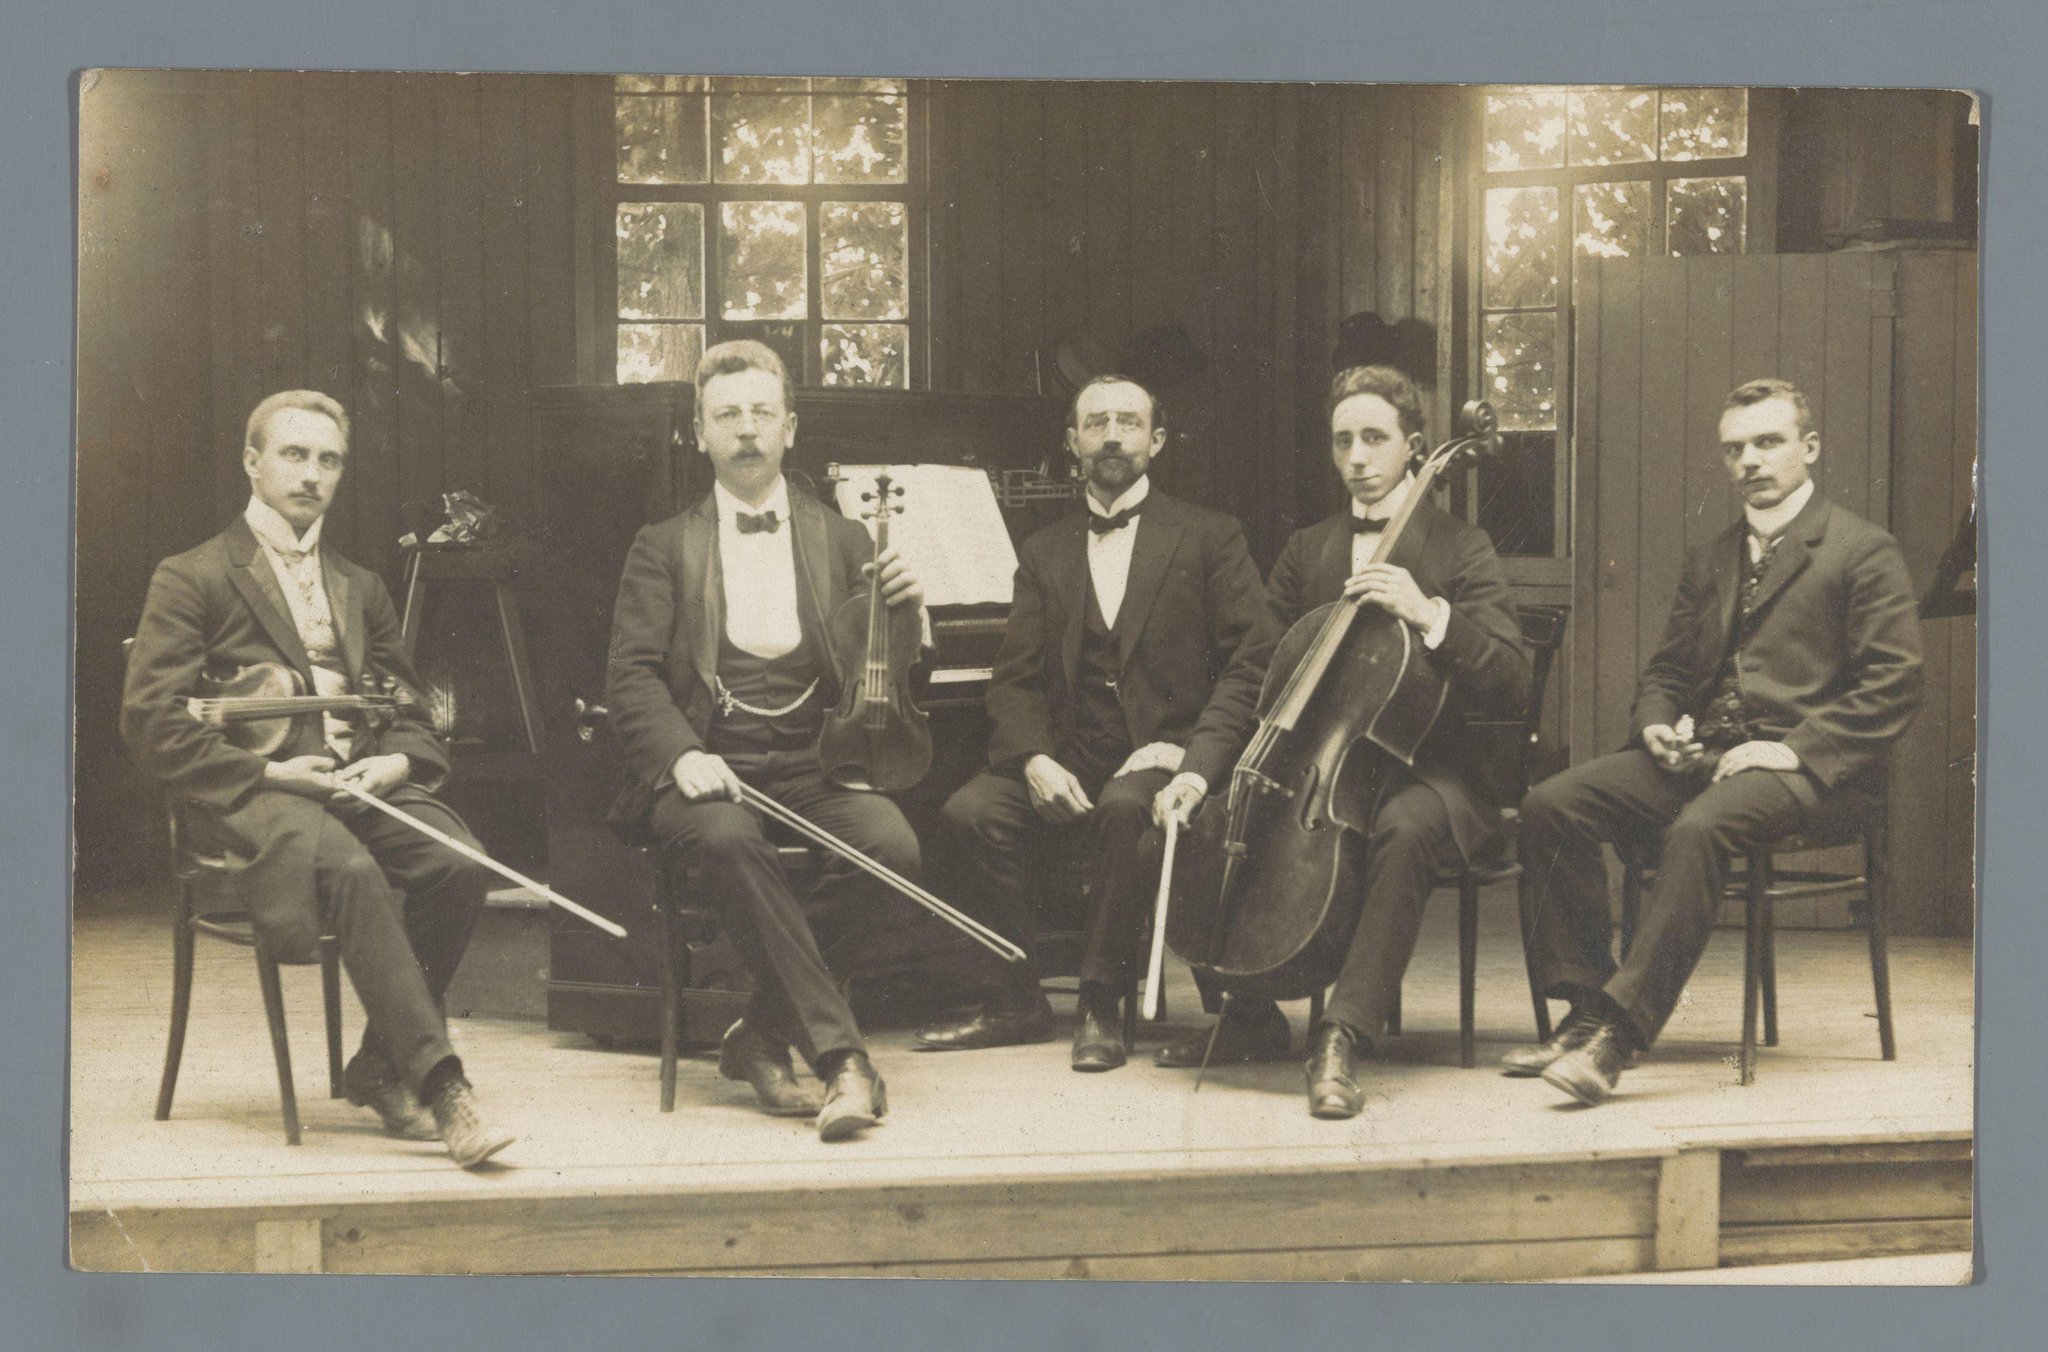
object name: photograph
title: Groepsportret van een muziekensemble op een podium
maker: johan joachim cohnen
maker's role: publisher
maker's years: 1885-1947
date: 1911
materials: photographic support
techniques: gelatin silver print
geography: valkenburg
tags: small group of musicians, chamber orchestra, jazz band, interior ~ representation of a building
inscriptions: inscription: ‘Zür Erinnerung (...) Hupfernagel’